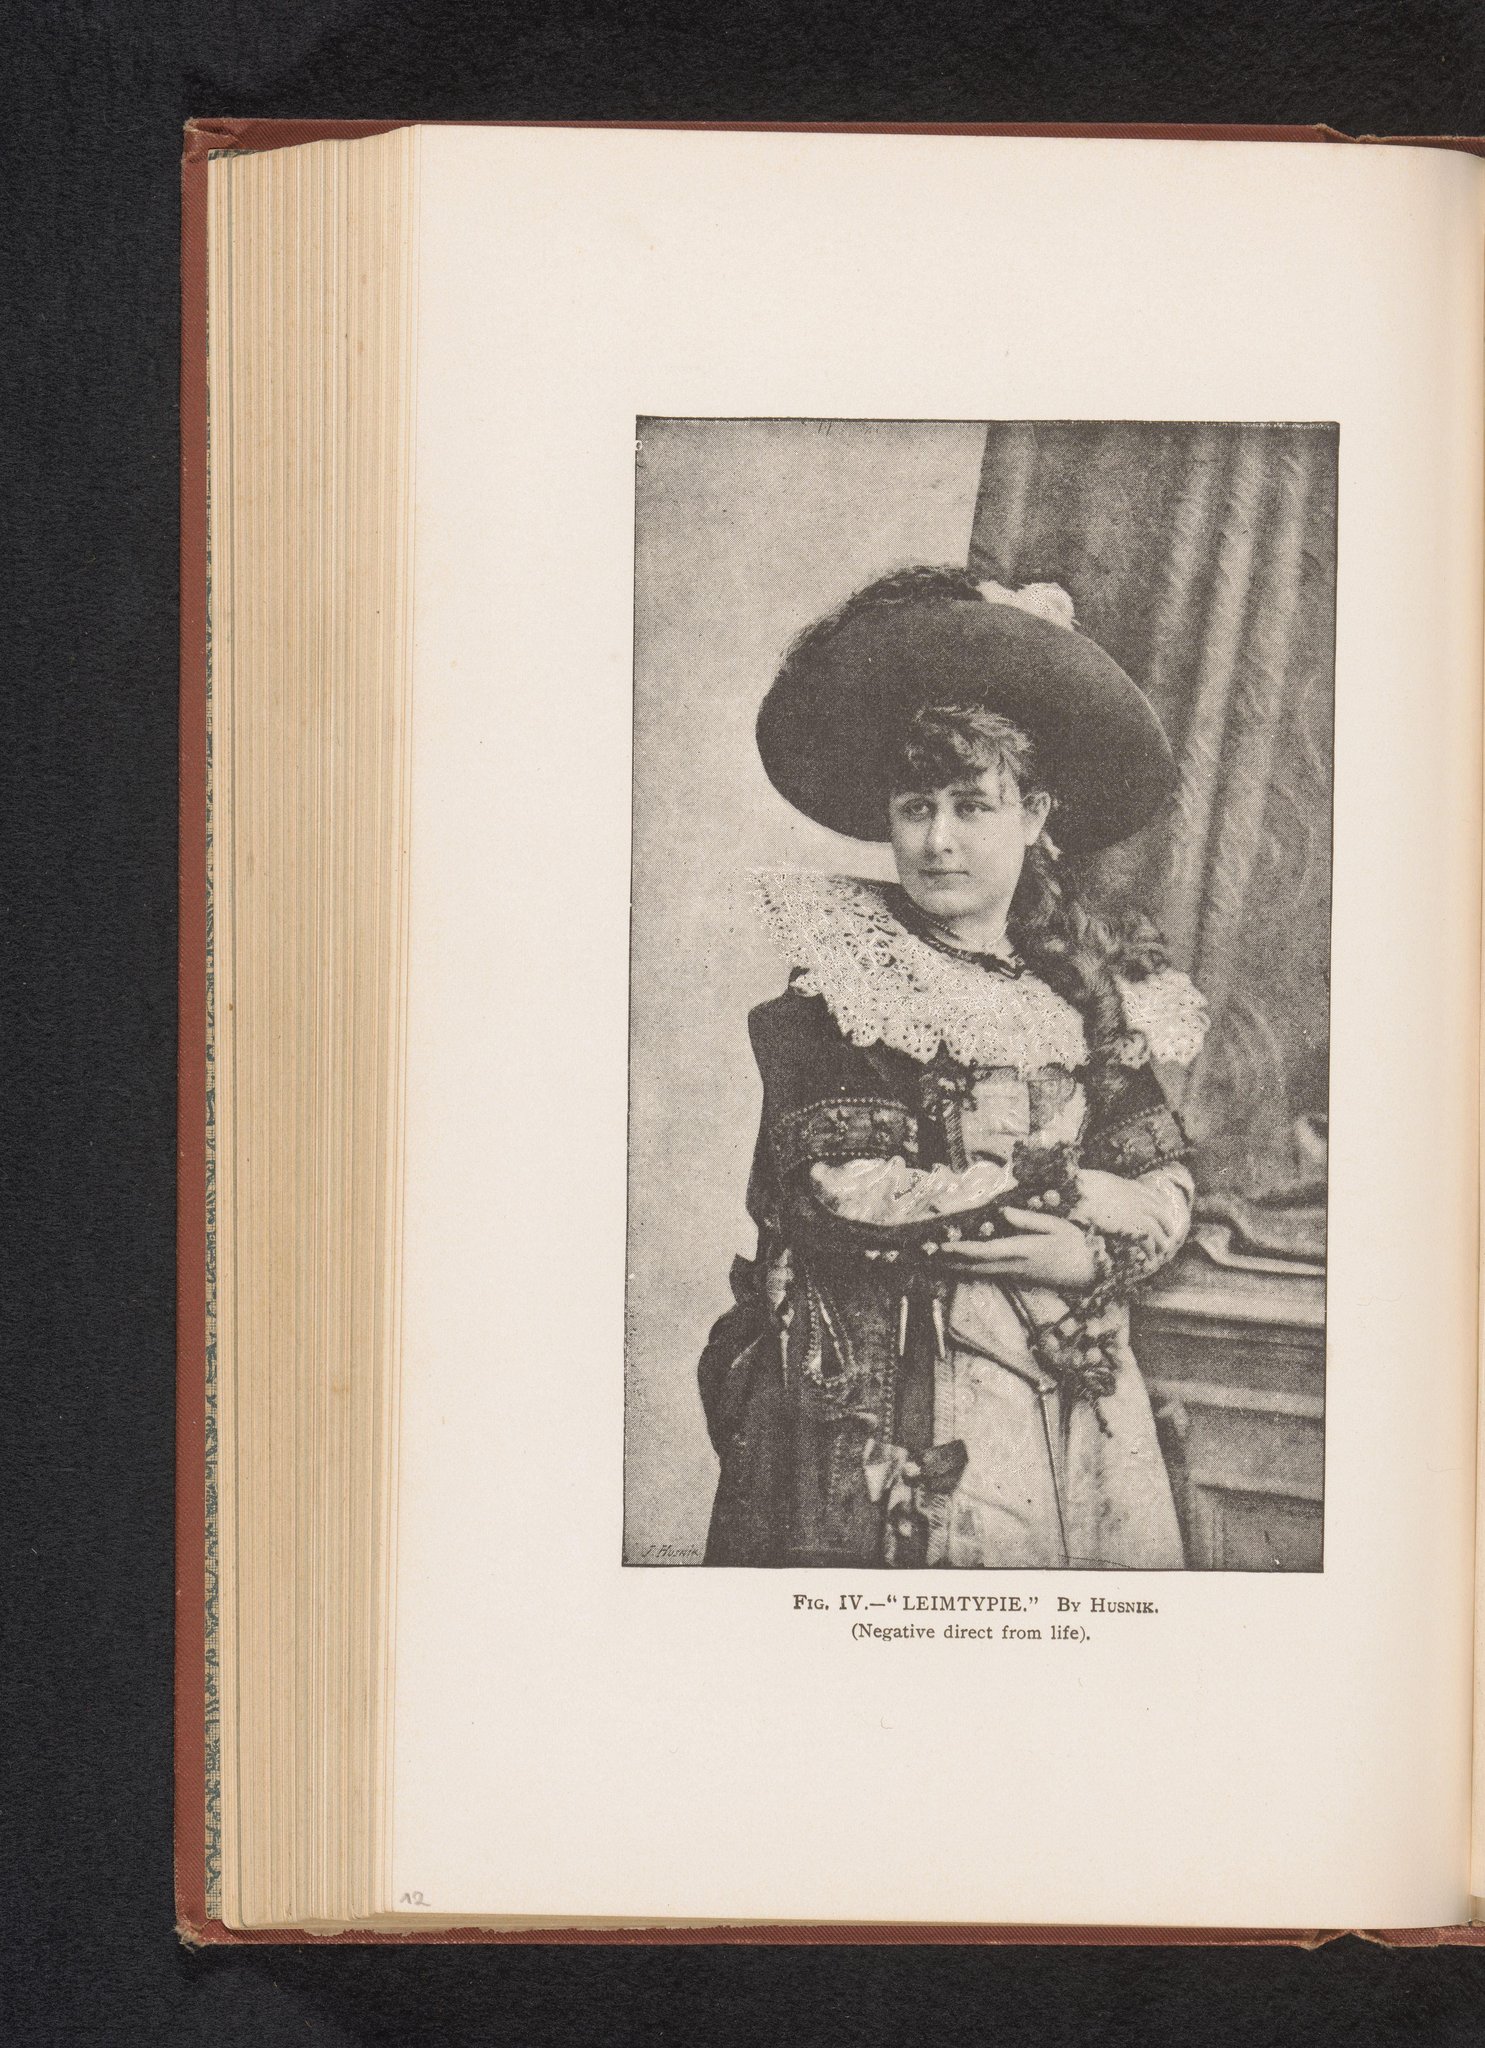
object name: page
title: Portret van een onbekende vrouw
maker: jakub husnik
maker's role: clichémaker, fotograaf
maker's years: 1837-1916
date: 1884-1889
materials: paper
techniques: autotype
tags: historical persons not known by name - bb - woman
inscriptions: inscription: ‘(Negative direct from life).’, inscription: ‘Fig. IV. - "Leimtypie"’